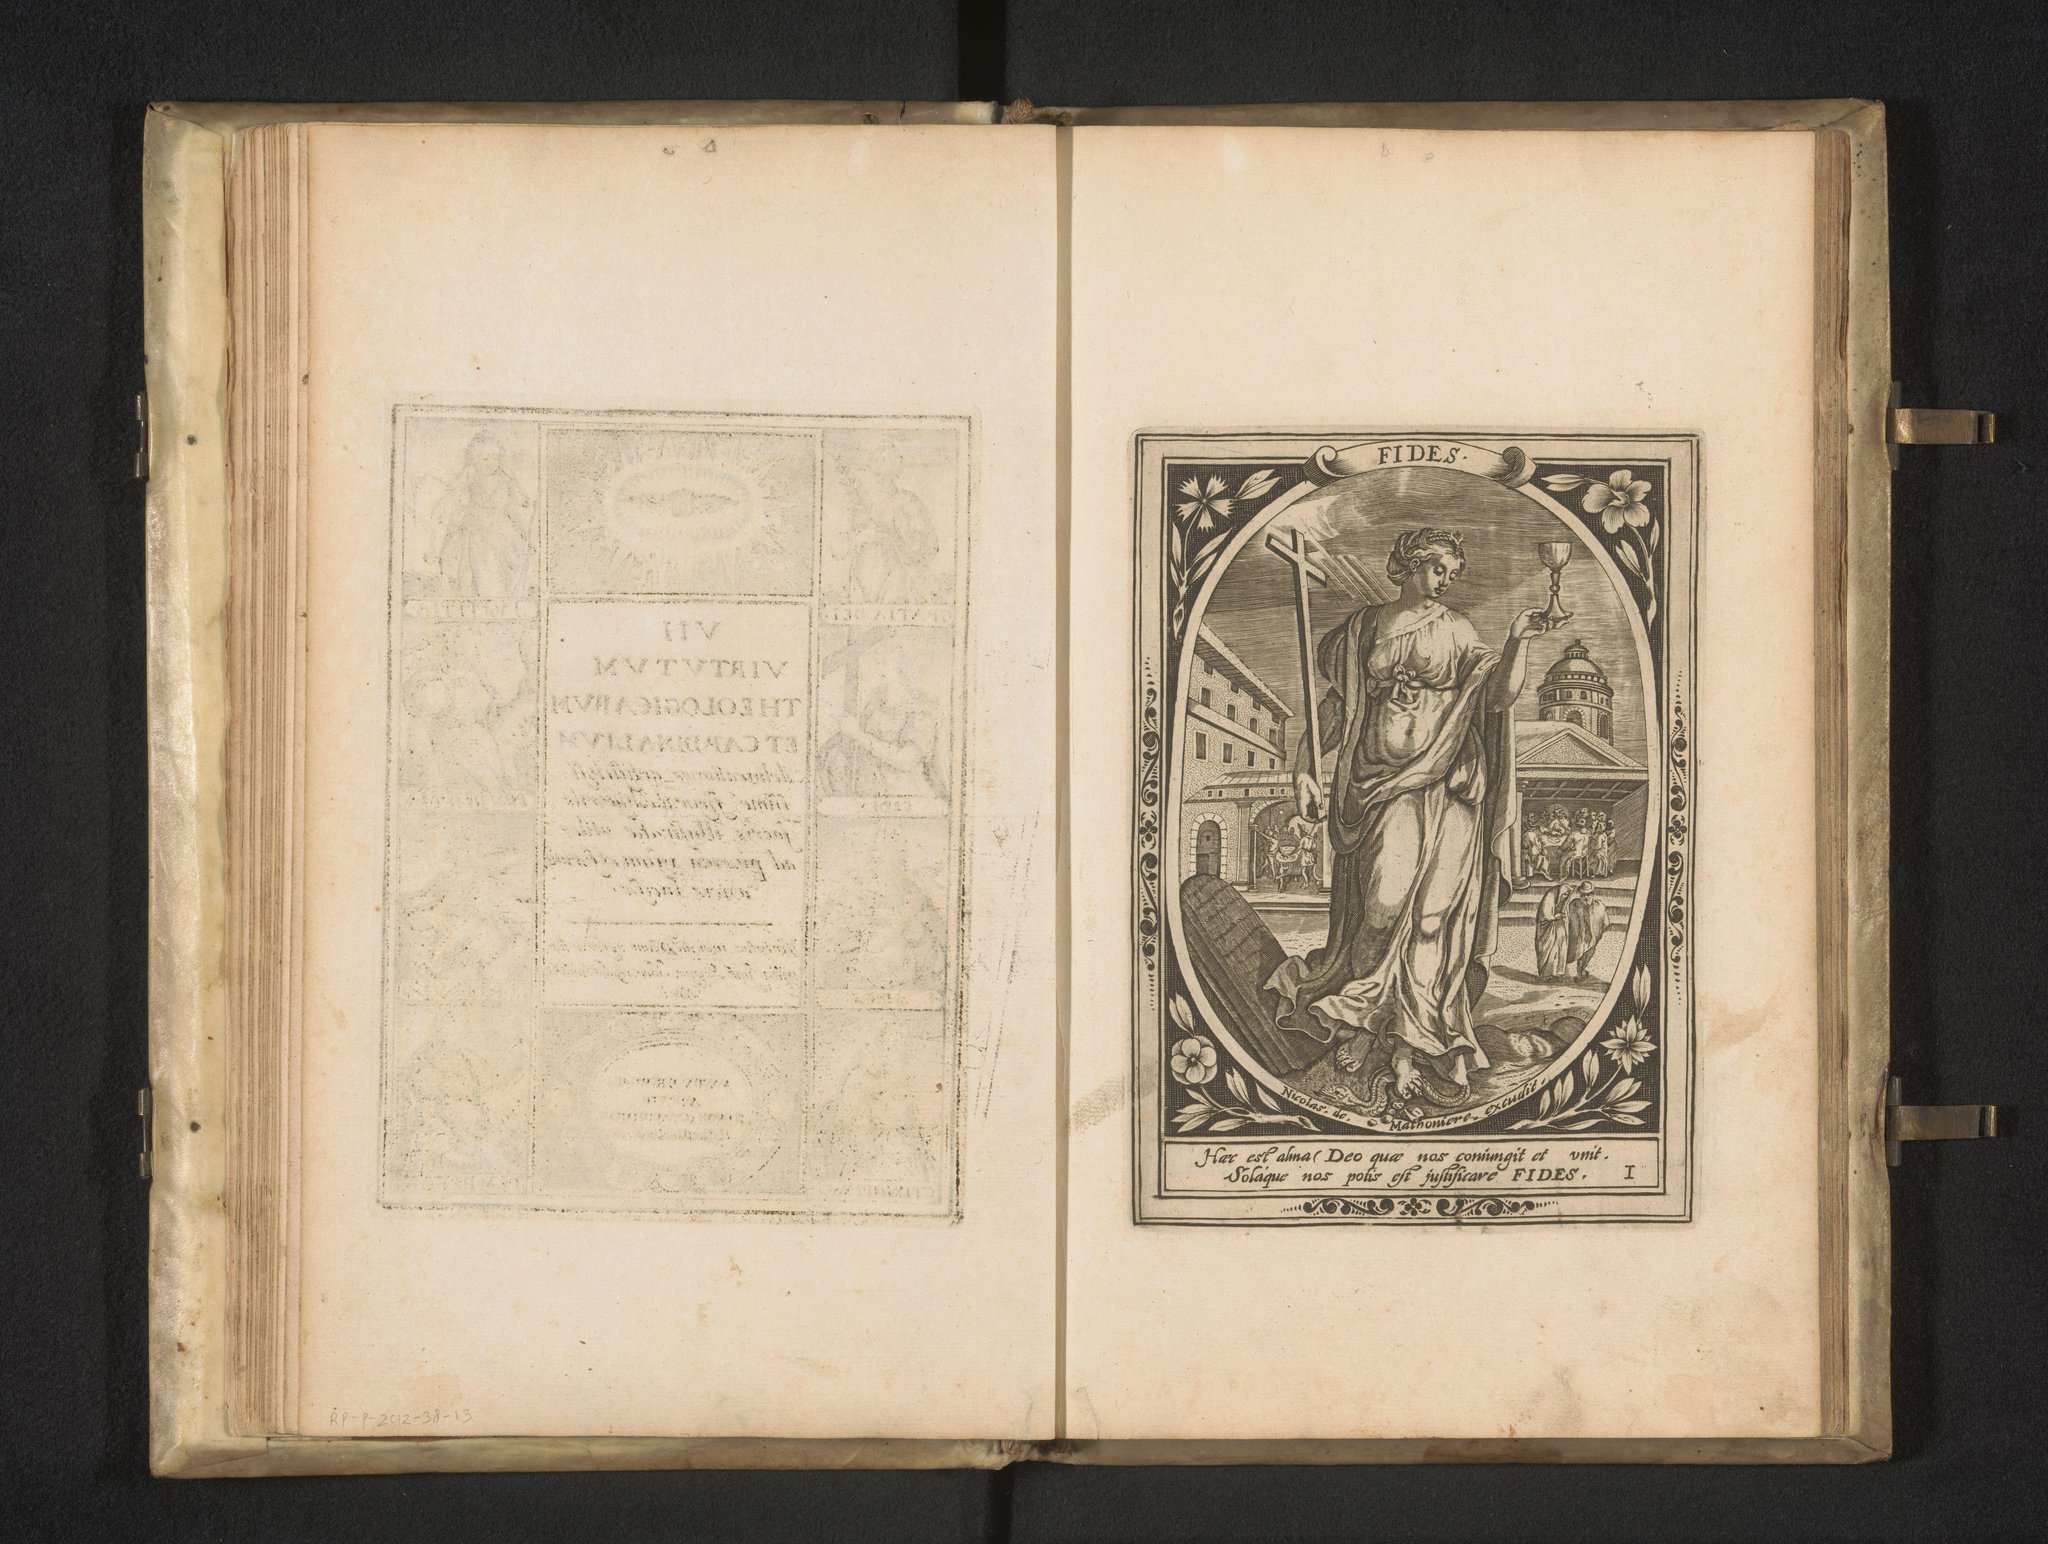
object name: print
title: Zeven theologische en kardinale deugden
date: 1600-1670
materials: paper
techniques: engraving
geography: paris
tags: faith, 'fides'; 'fede', 'fede catholica', 'fede christiana', 'fede christiana catholica' (ripa) ~ one of the three theological virtues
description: Het Geloof (Fides). Genummered rechtsonder: 1. Onderdeel van de serie van zeven theologische en kardinale deugden. Onderdeel van een album met voornamelijk christelijke voorstellingen.